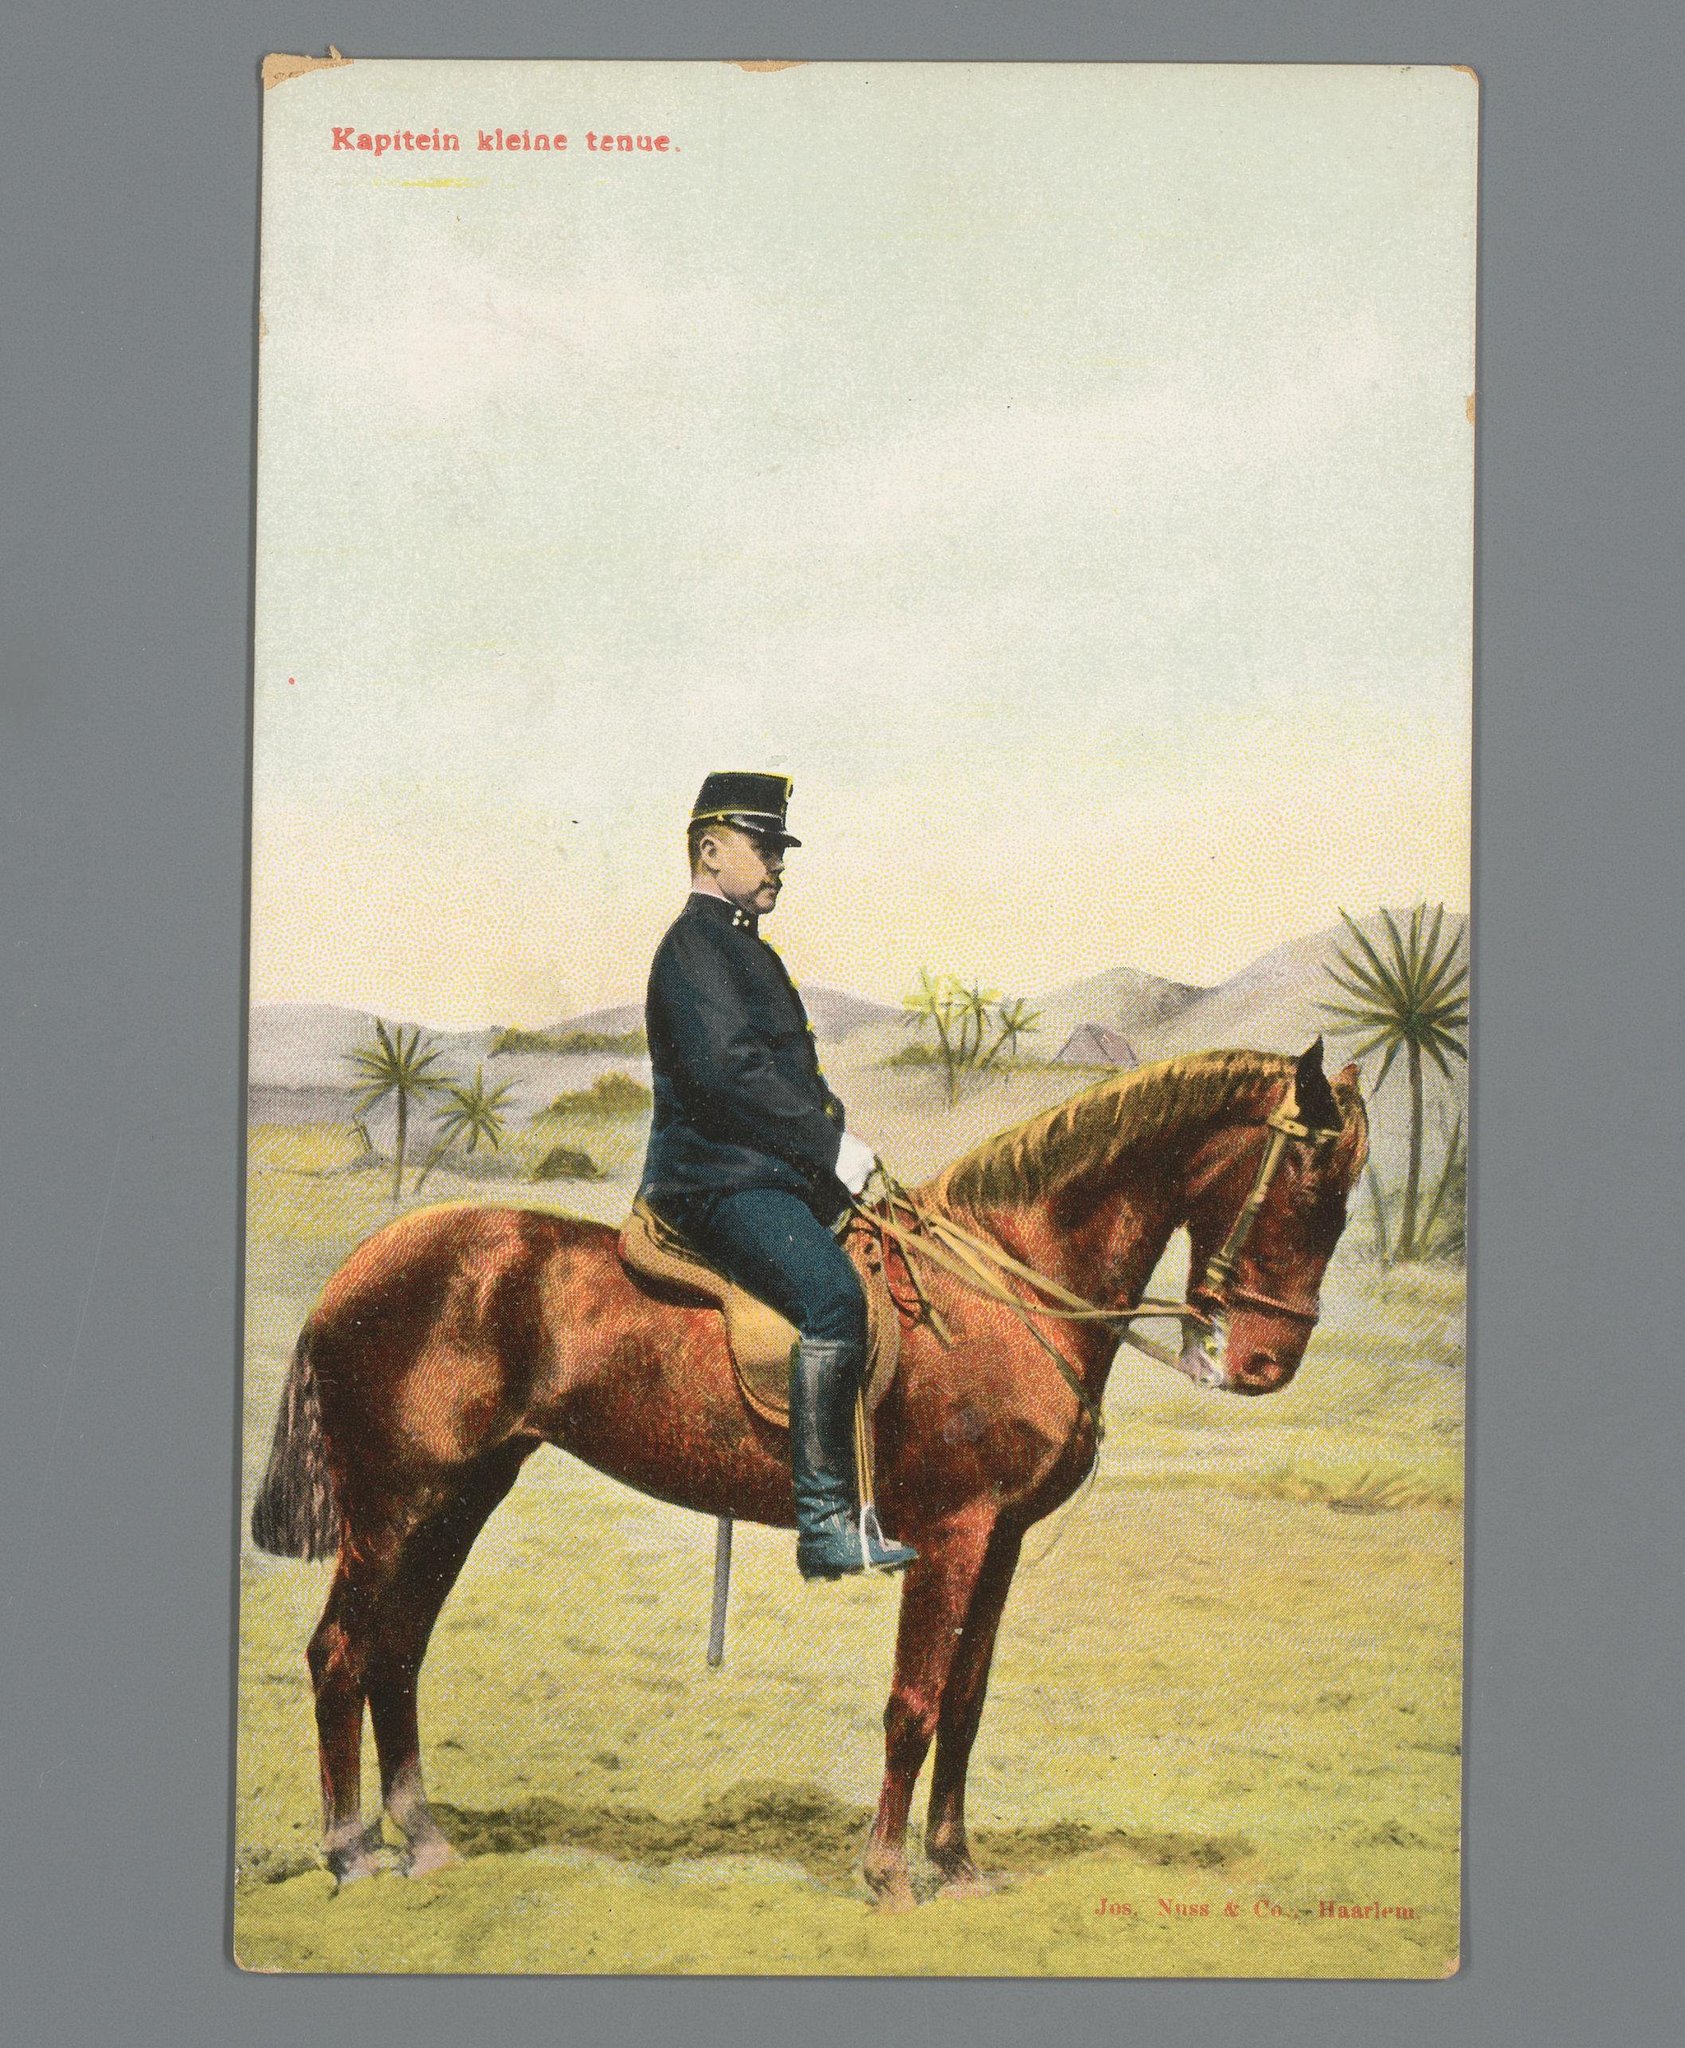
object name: photomechanical print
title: Onze land- en zeemacht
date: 1905-1909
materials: paper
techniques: four-color autotype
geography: haarlem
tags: anonymous historical person portrayed, officer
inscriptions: inscription: ‘BRIEFKAART/ (CARTE POSTALE)/ Algemeene Postvereeniging (Union postale universelle)/ DRUKWERK/ No. 8 AUTEURSRECHT VERZEKERD OVEREENKOMSTIG/ DE WET, 28 JUNI 1881, STAATSBLAD NO 124 .'./ Bij verzending/ als "drukwerk" de/ woorden briefkaart/ carte postale door-/ schrappen en alleen/ naam en datum/ er op schrijven.’, inscription: ‘68, Uniform’